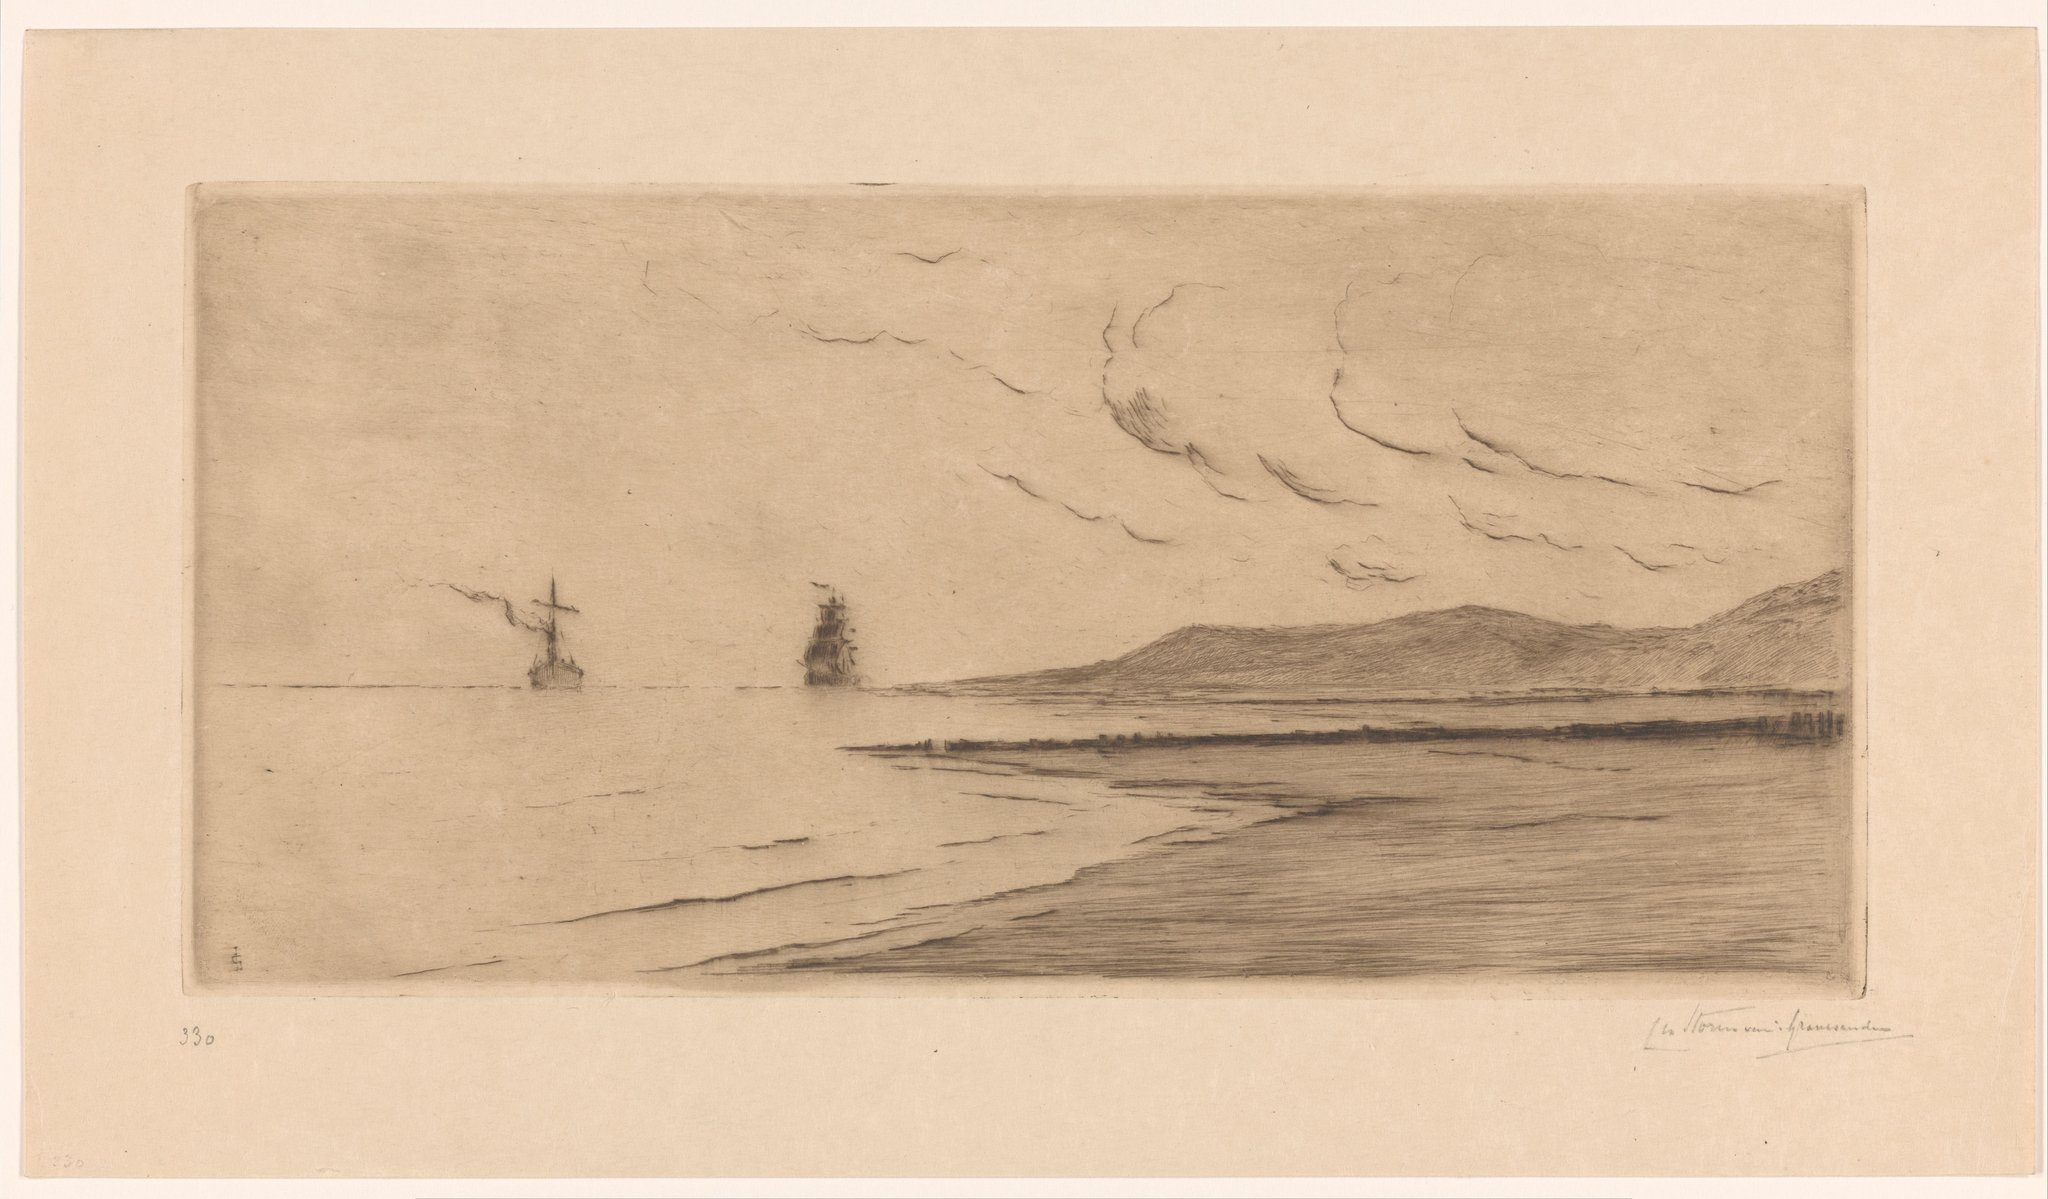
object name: print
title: La plage près West Kapelle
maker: carel nicolaas storm van s-gravesande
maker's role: draughtsman, print maker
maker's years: 1841-1924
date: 1889-1902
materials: paper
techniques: drypoint, intaglio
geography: netherlands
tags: sailing-ship, sailing-boat, beach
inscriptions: collector's mark: Lugt 2228, number: ‘330’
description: Mogelijk vermeld in: Storm van 's-Gravesande, Charles. Catalogue des eaux-fortes et lithographies. New York: s.n., 1903, of in een onbekende latere uitgave van het manuscript. Vermoedelijk vermeld als catalogusnummer 330.